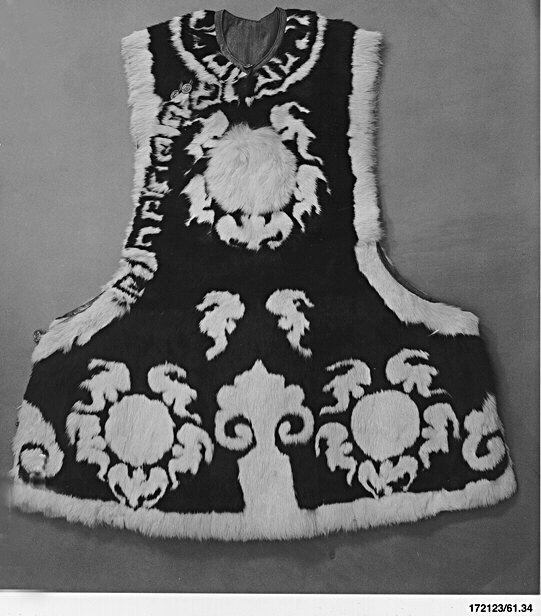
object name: overvest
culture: chinese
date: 1801-1900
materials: fur